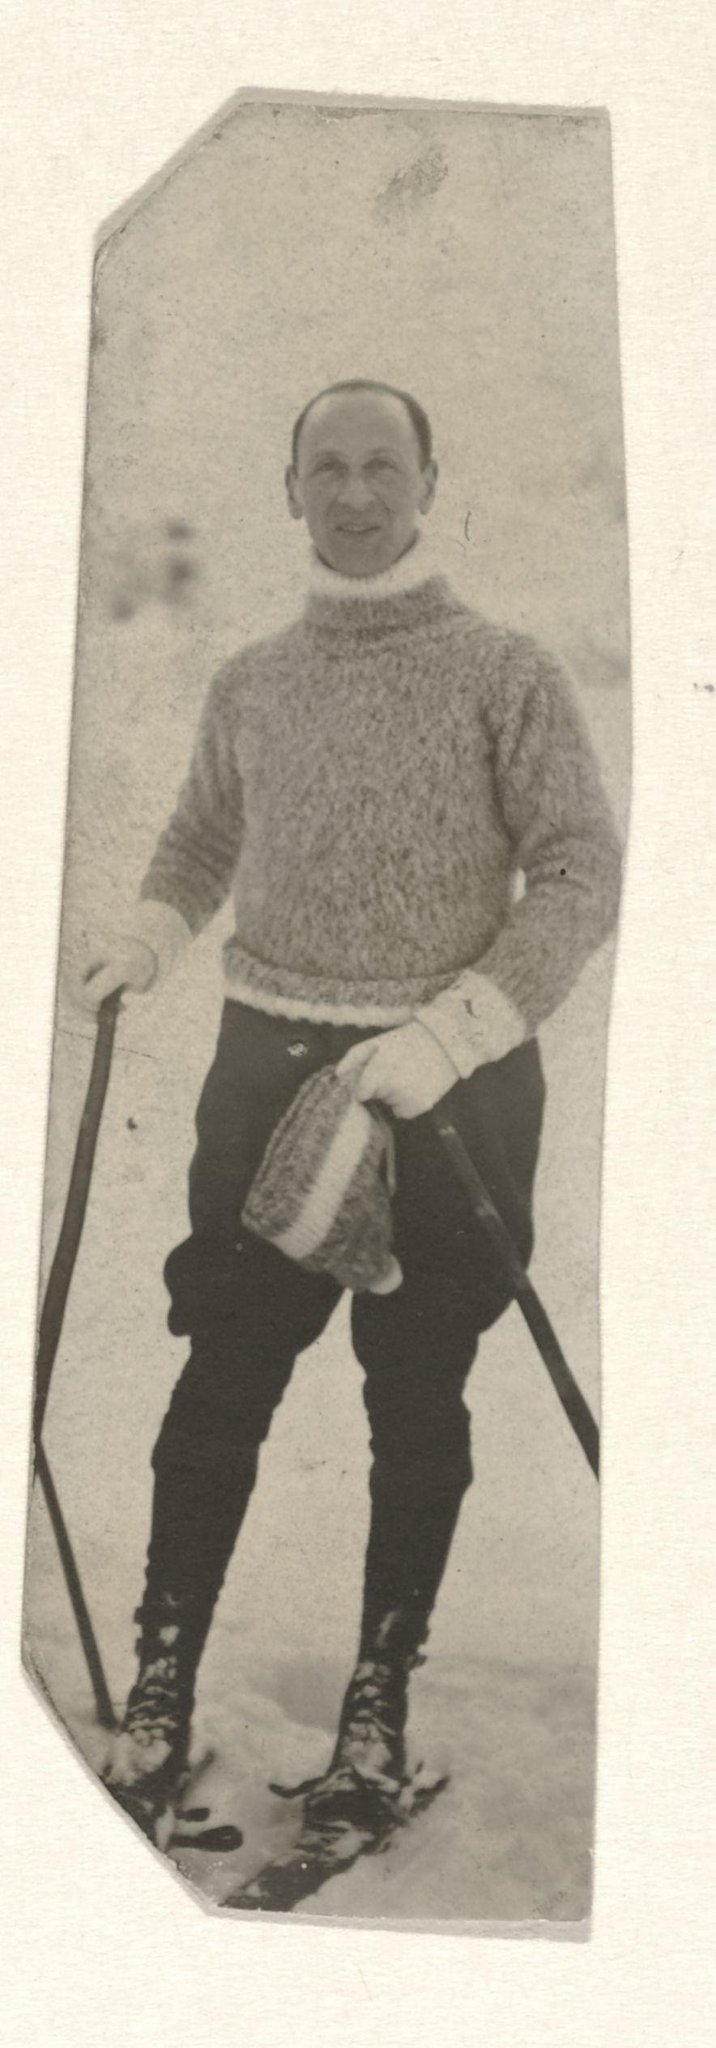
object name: photograph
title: Arthur Moos staand op skies in de sneeuw, in coltrui en donkere broek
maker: Anonymous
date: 1915-1922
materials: photographic support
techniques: gelatin silver print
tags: arthur moos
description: Arthur Moos staand op skies in de sneeuw, in coltrui en donkere broek.